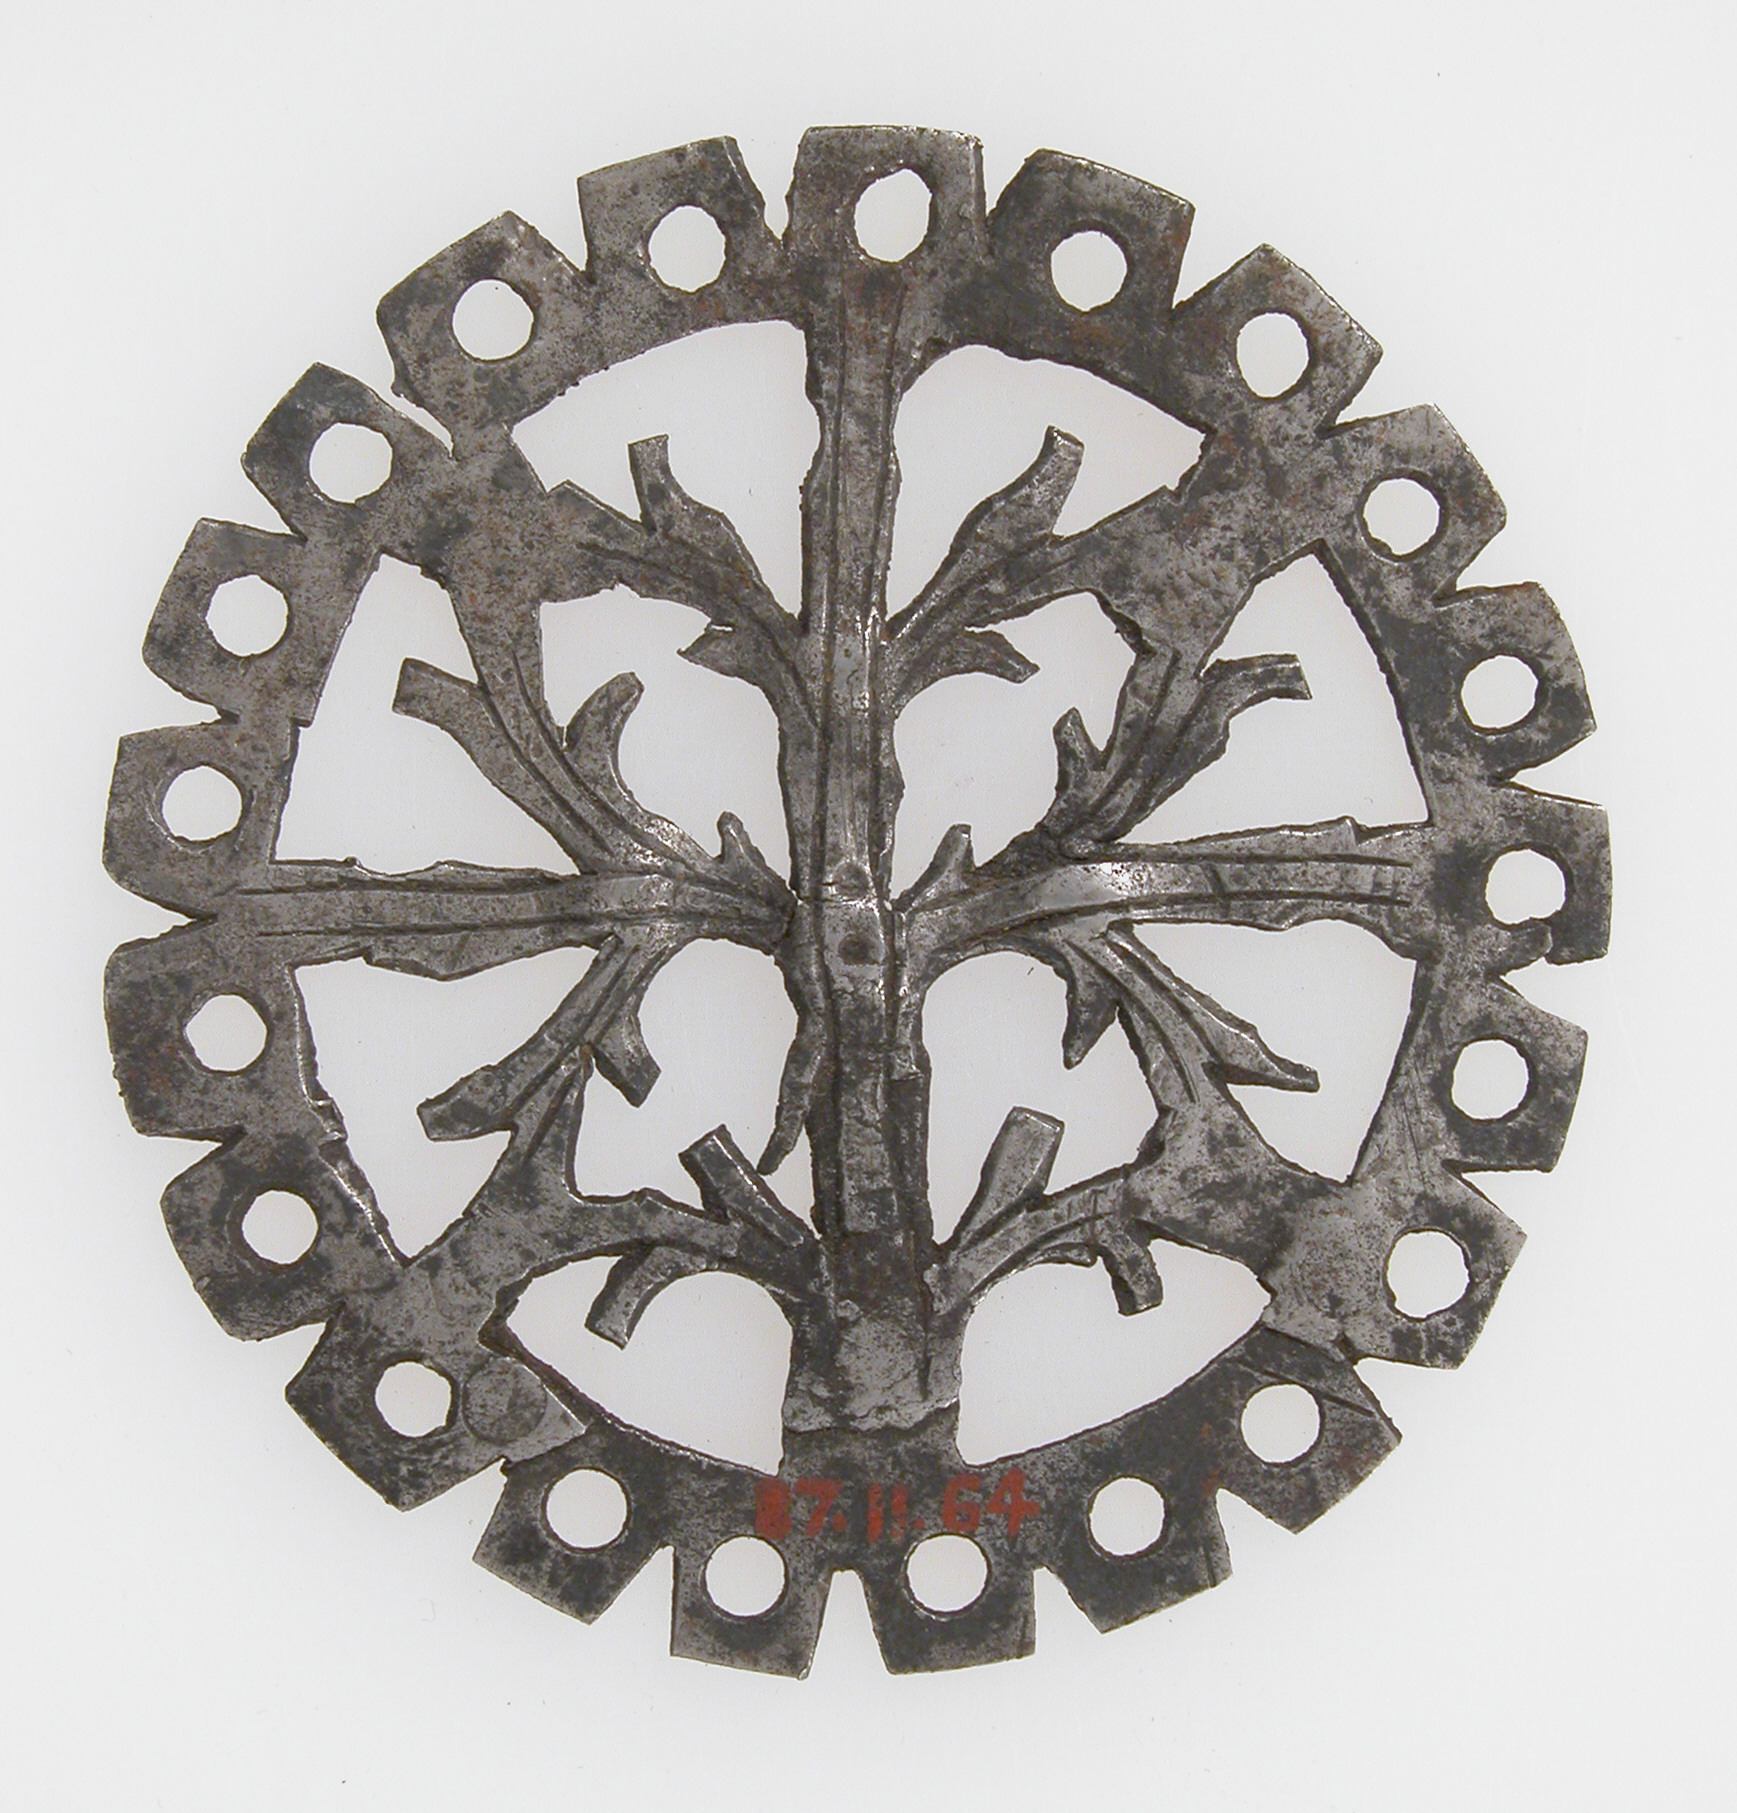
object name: door ornament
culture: german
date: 1401-1500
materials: iron